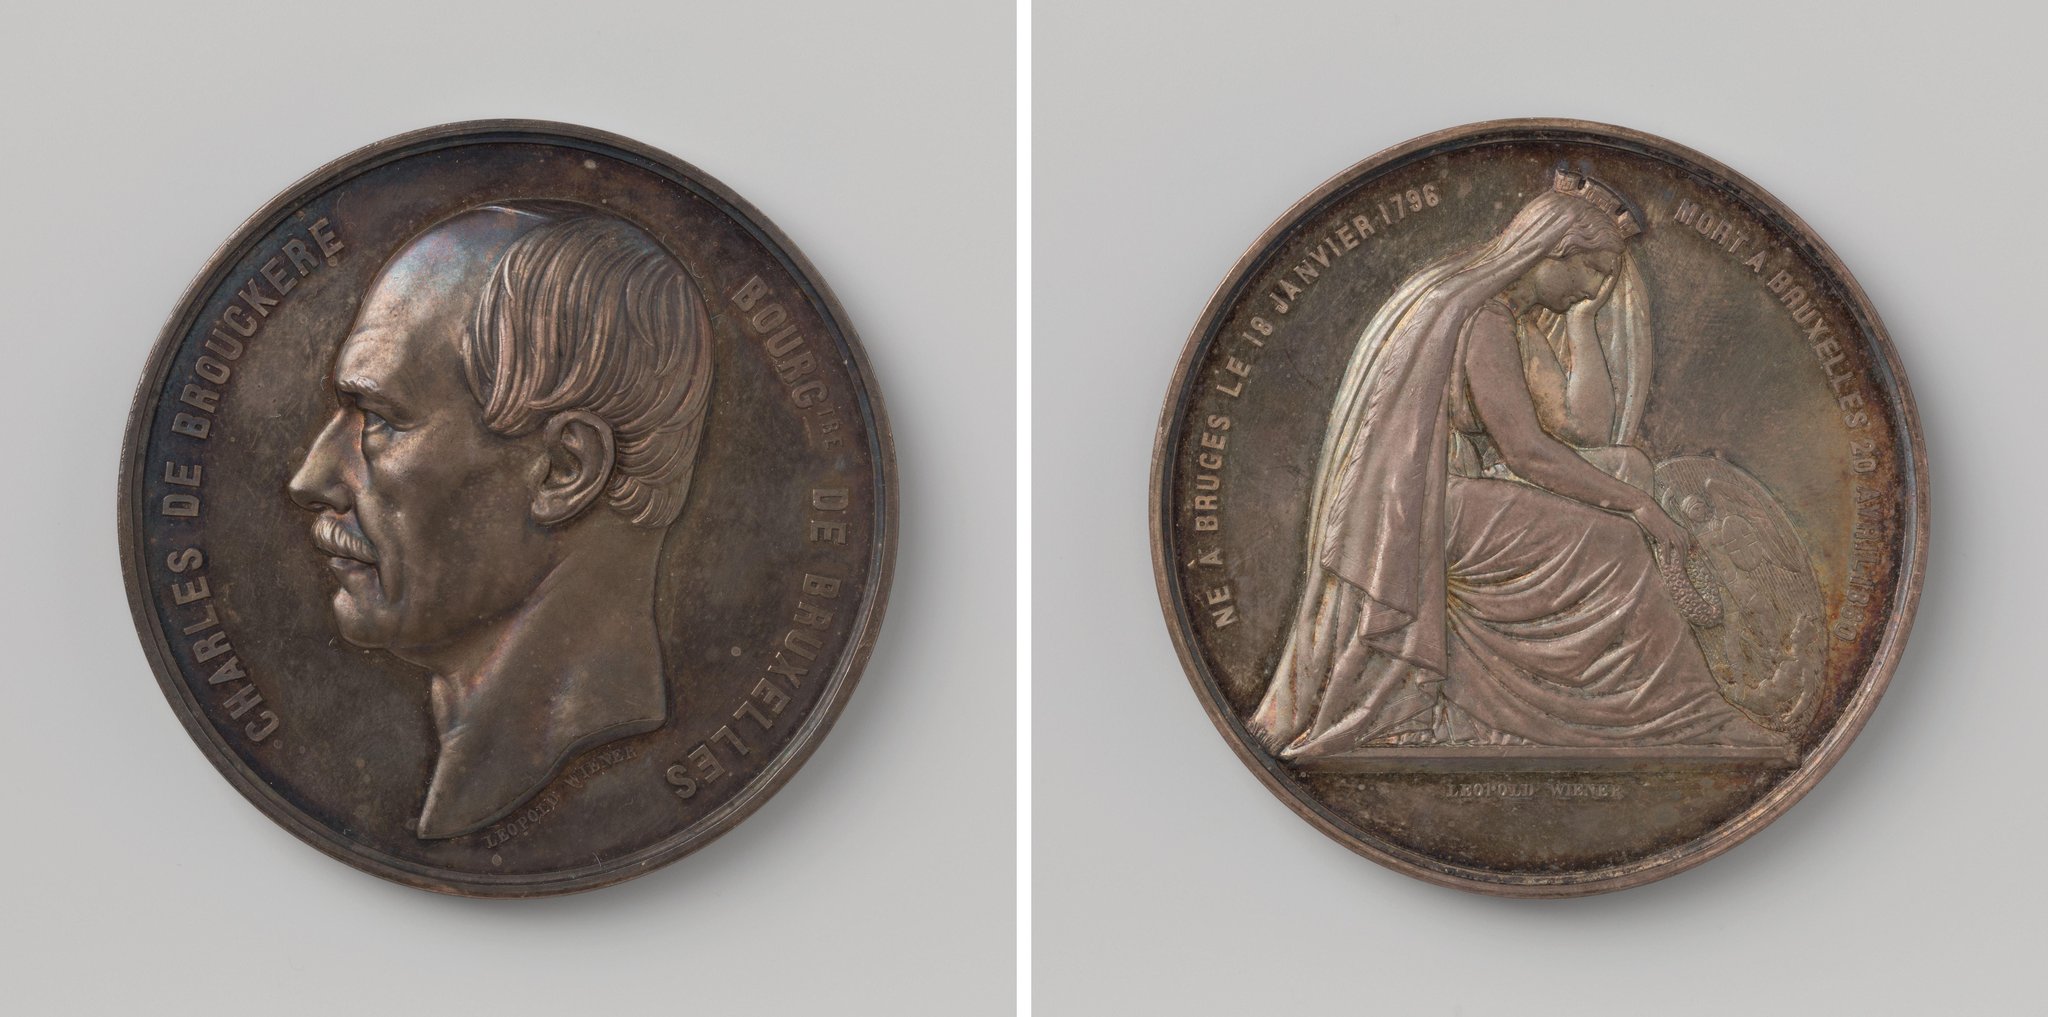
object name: history medal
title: Overlijden van Charles de Brouckere, burgemeester van Brussel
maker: leopold wiener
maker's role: sculptor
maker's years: 1823-1891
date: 1860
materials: silver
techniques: striking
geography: brussels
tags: bruges, brussels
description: Zilveren penning. Voorzijde: borststuk man binnen omschrift. Keerzijde: gekroonde vrouw, voorstellende stad Brussel, zit rouwend bij wapenschild, met krans in rechterhand en hoofd steunend op linkerarm binnen omschrift; afsnede: signatuur